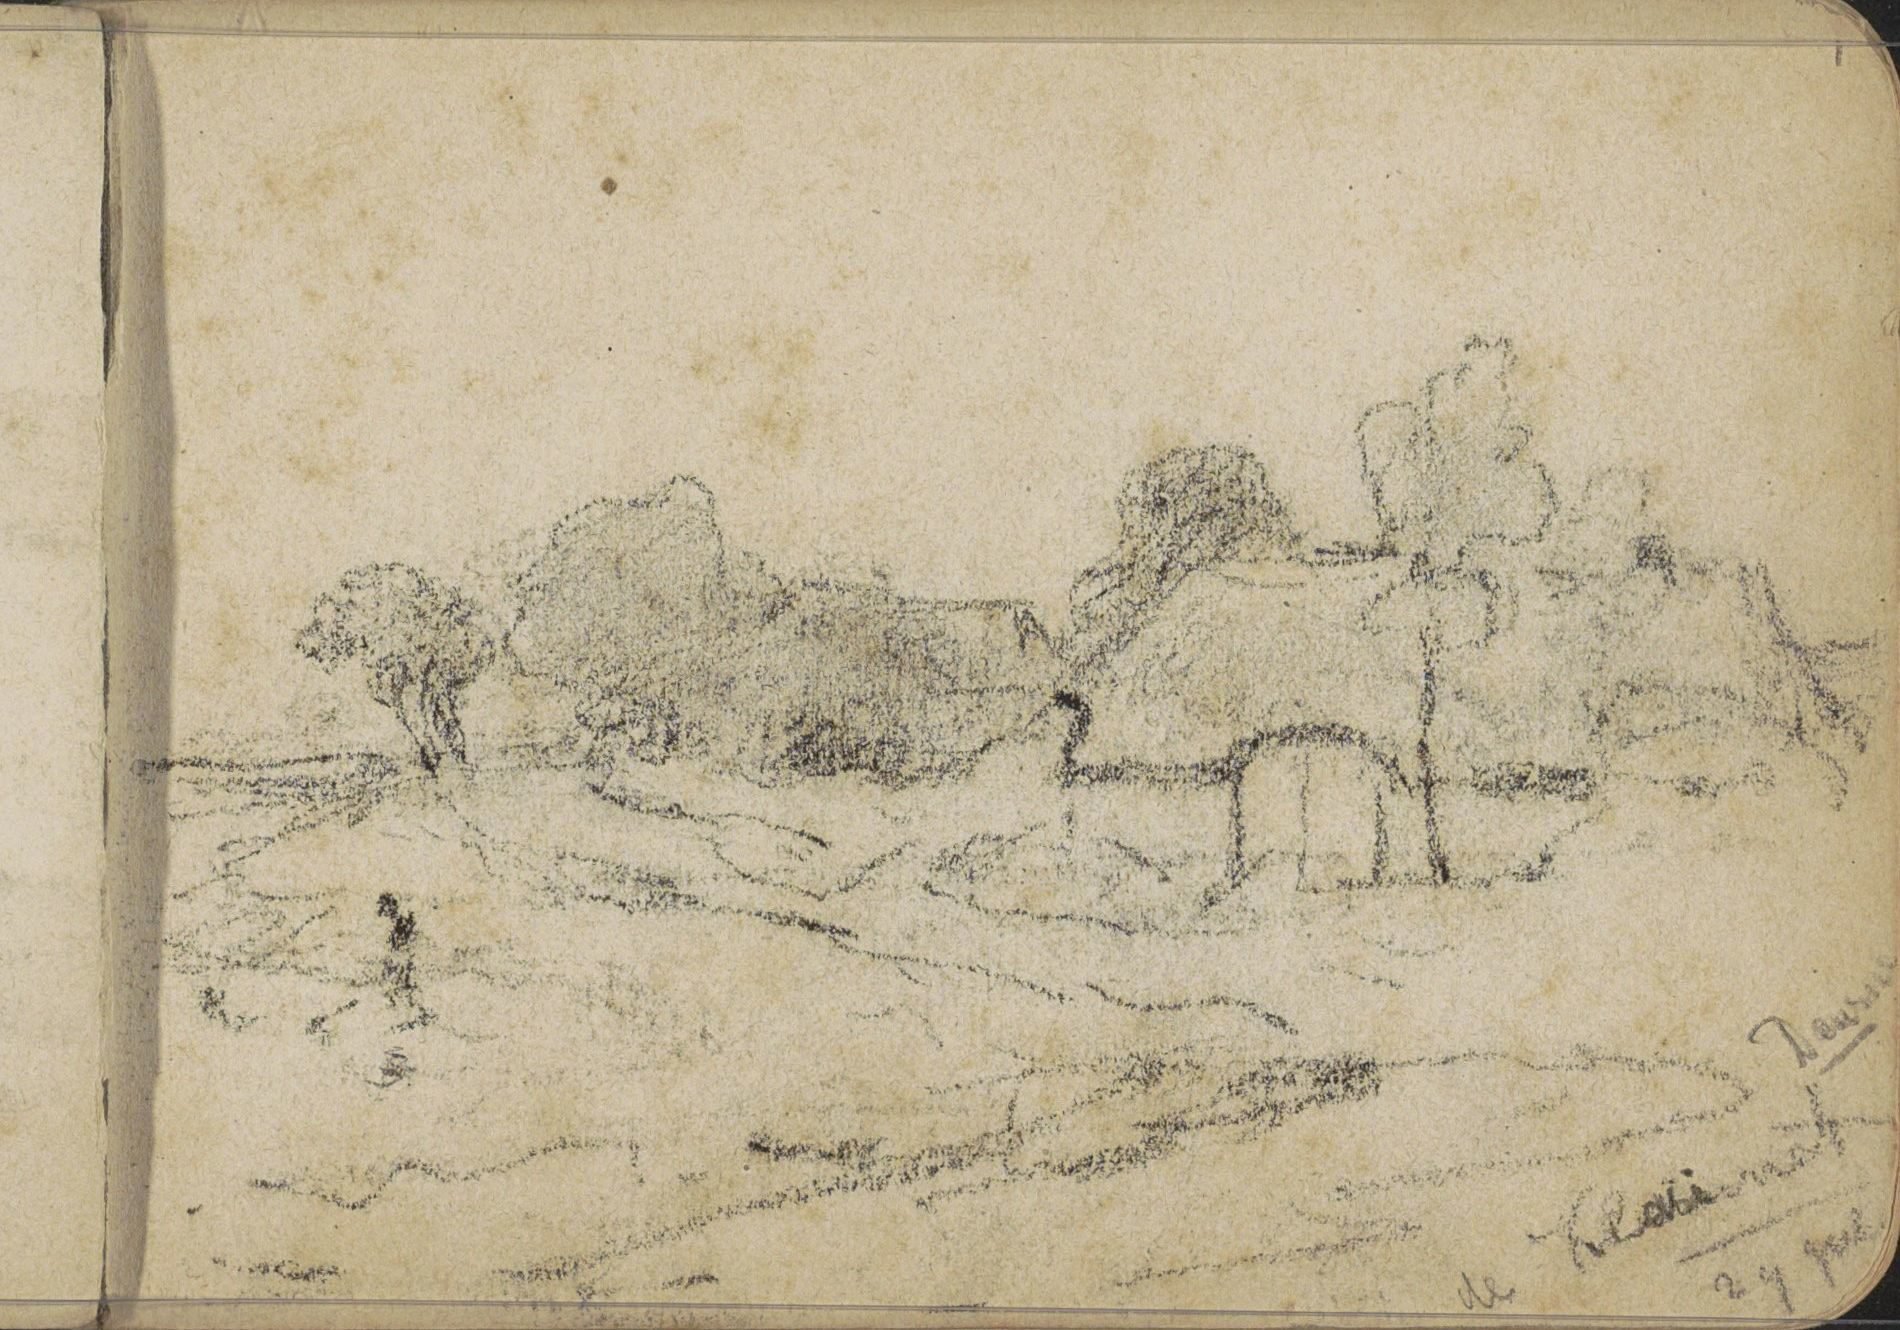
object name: sketchbook leaf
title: Boerderij bij Deurne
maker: willem cornelis rip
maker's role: draughtsman, painter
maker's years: 1856-1922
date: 1807-1897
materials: chalk, paper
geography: deurne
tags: farm (building)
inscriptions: date and inscription: ‘Deurne/ de Kl[...]/ 29 Jul’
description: Blad 1 recto uit een schetsboek met 44 bladen.